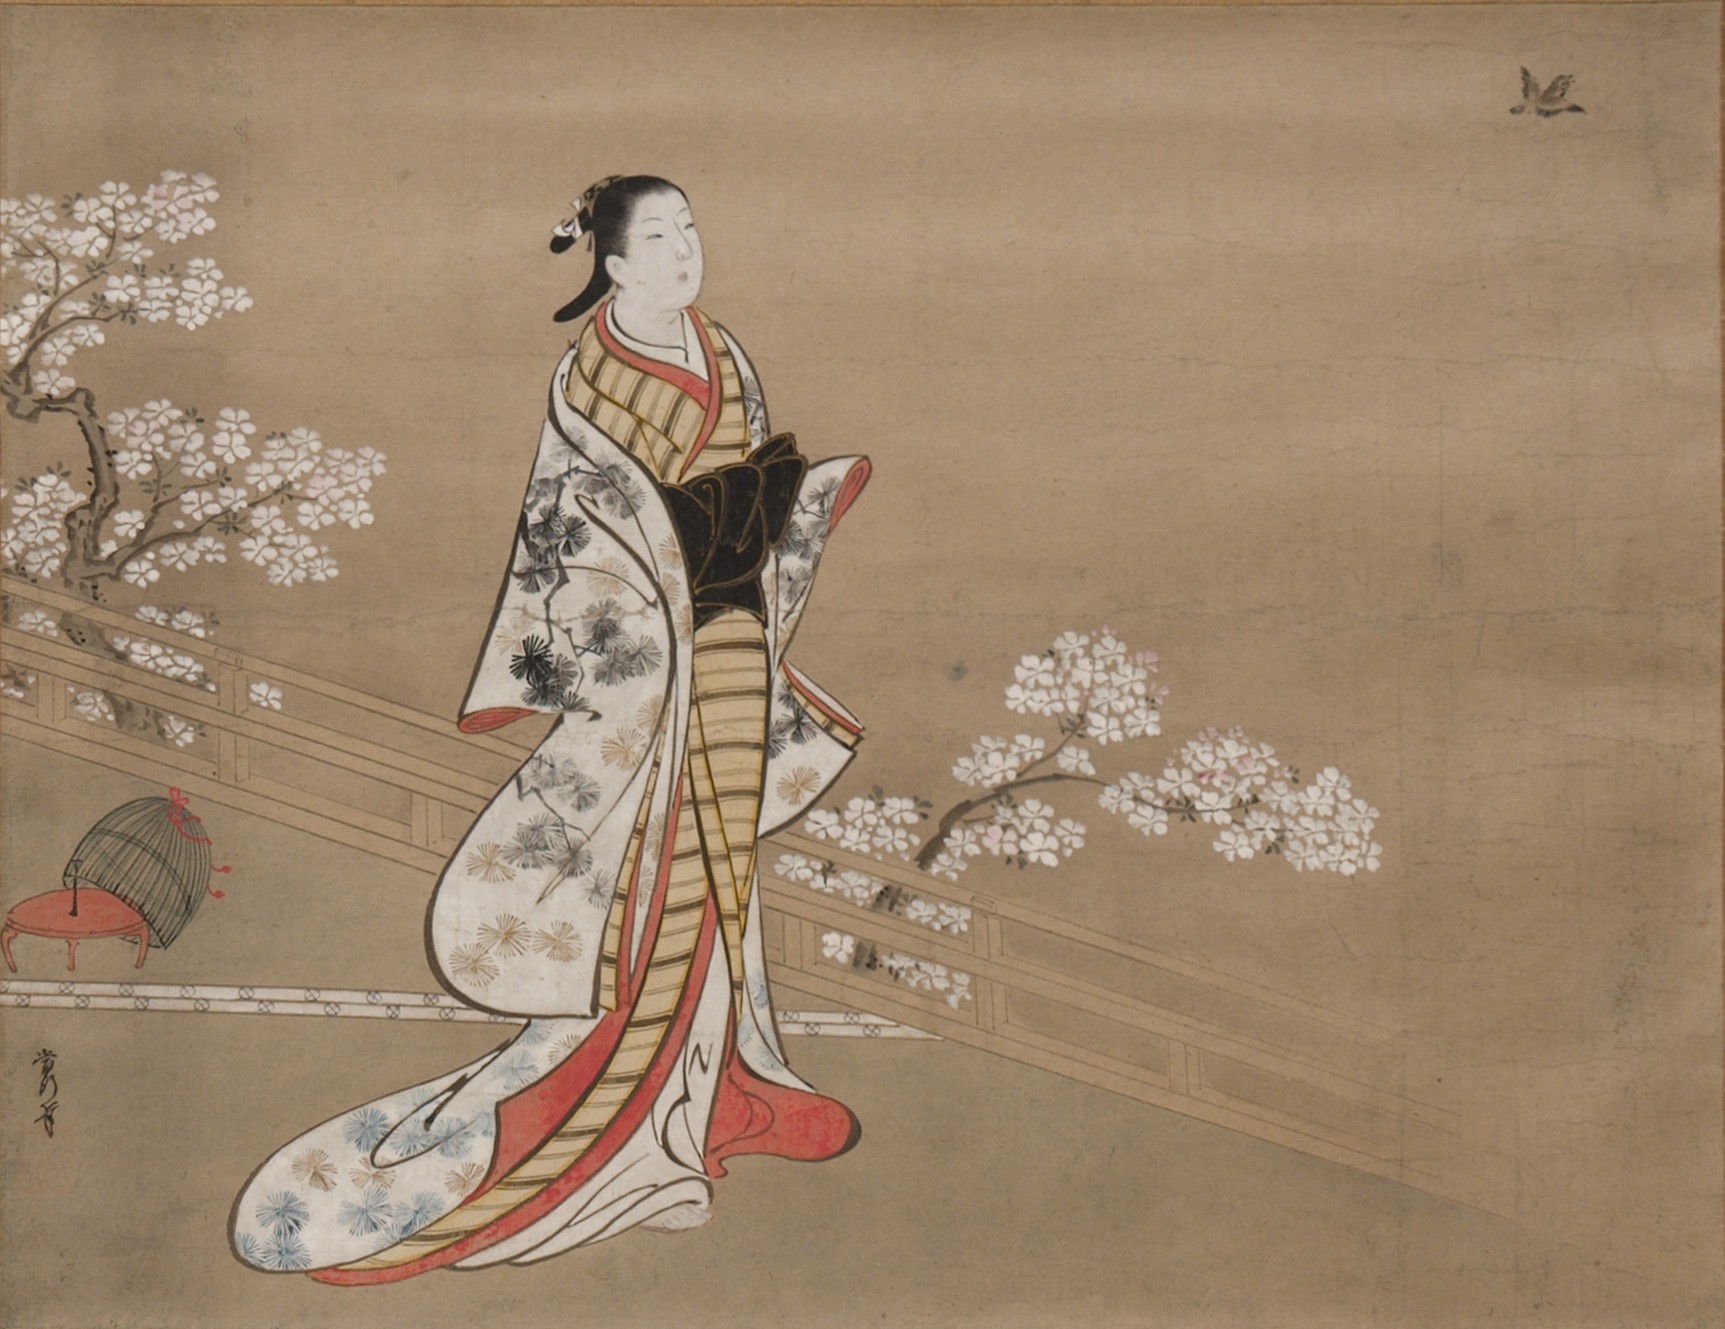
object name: hanging scroll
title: Parody of Murasaki, from "Lavender" (Wakamurasaki), chapter 5 of the Tale of Genji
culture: japanese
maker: kawamata tsuneyuki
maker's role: artist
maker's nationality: japanese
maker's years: 1676-1741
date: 1701-1800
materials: ink, paper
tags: women,flowers